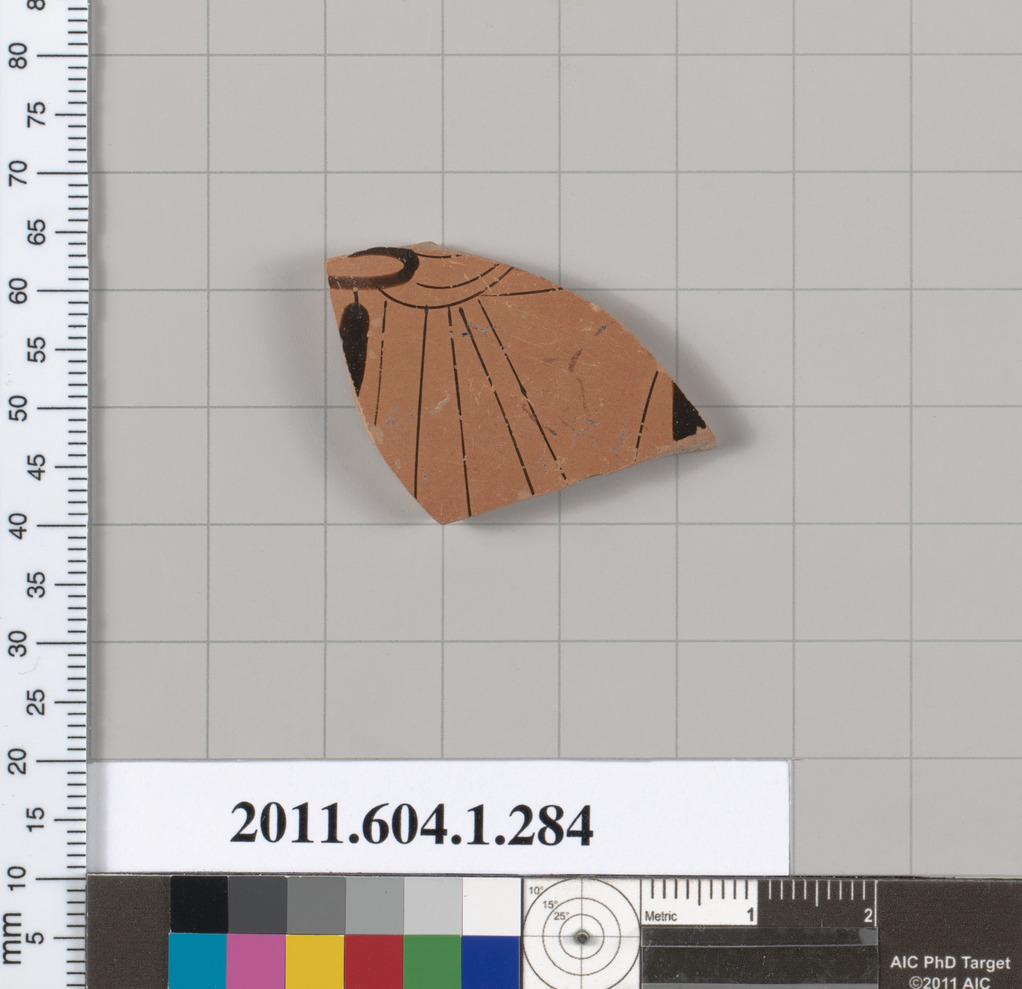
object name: kylix fragment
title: Terracotta fragment of a kylix (drinking cup)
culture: greek, attic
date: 475-451 BCE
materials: terracotta